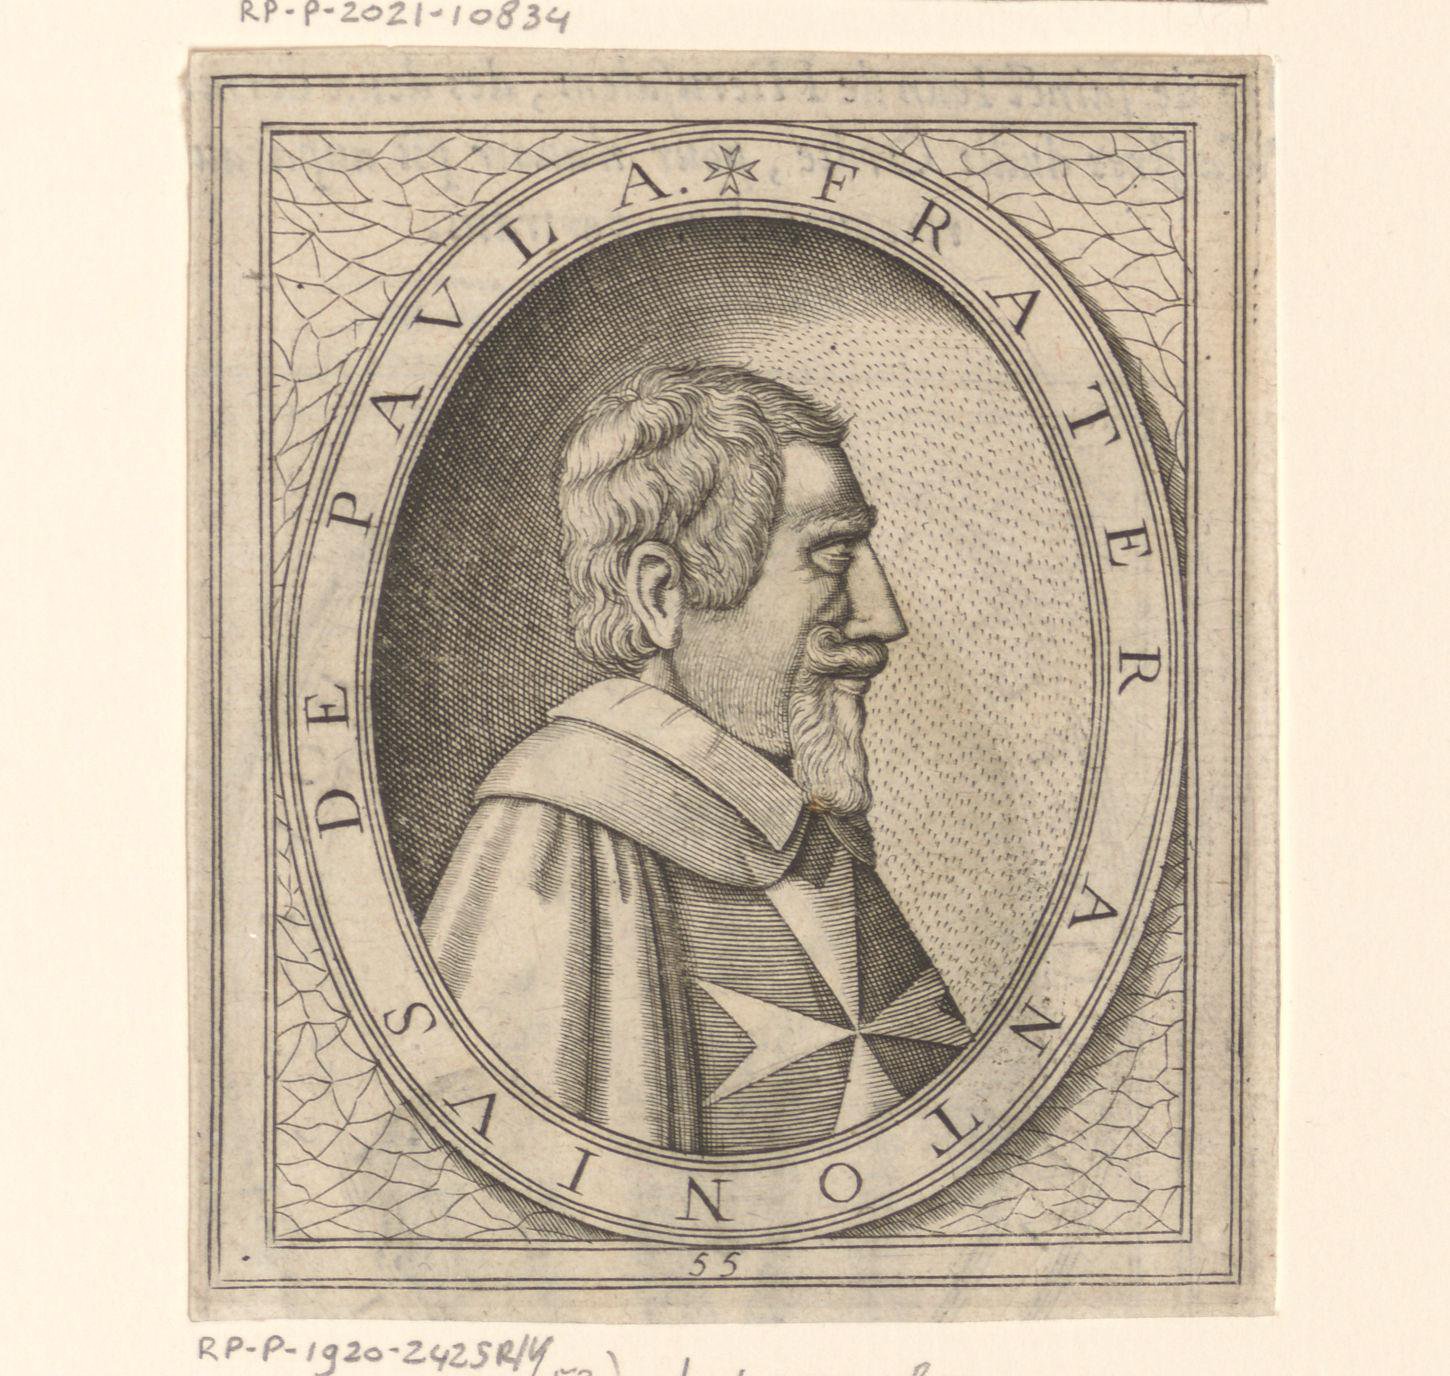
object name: print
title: Portret van Antoine de Paule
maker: Anonymous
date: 1643-1659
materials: paper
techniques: engraving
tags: historical persons, military orders, e.g.: knights templars, knights of malta, teutonic knights ~ roman catholic church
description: Prent mogelijk uit: Baudoin, Jean. Histoire des chevaliers de l'ordre de s. Jean de Hierusalem (...). Parijs: Jacques Dallin, 1643. Of uit: Baudoin, Jean. Histoire des chevaliers de l'ordre de s. Jean de Hierusalem (...). Parijs: Thomas Jolly, 1659.